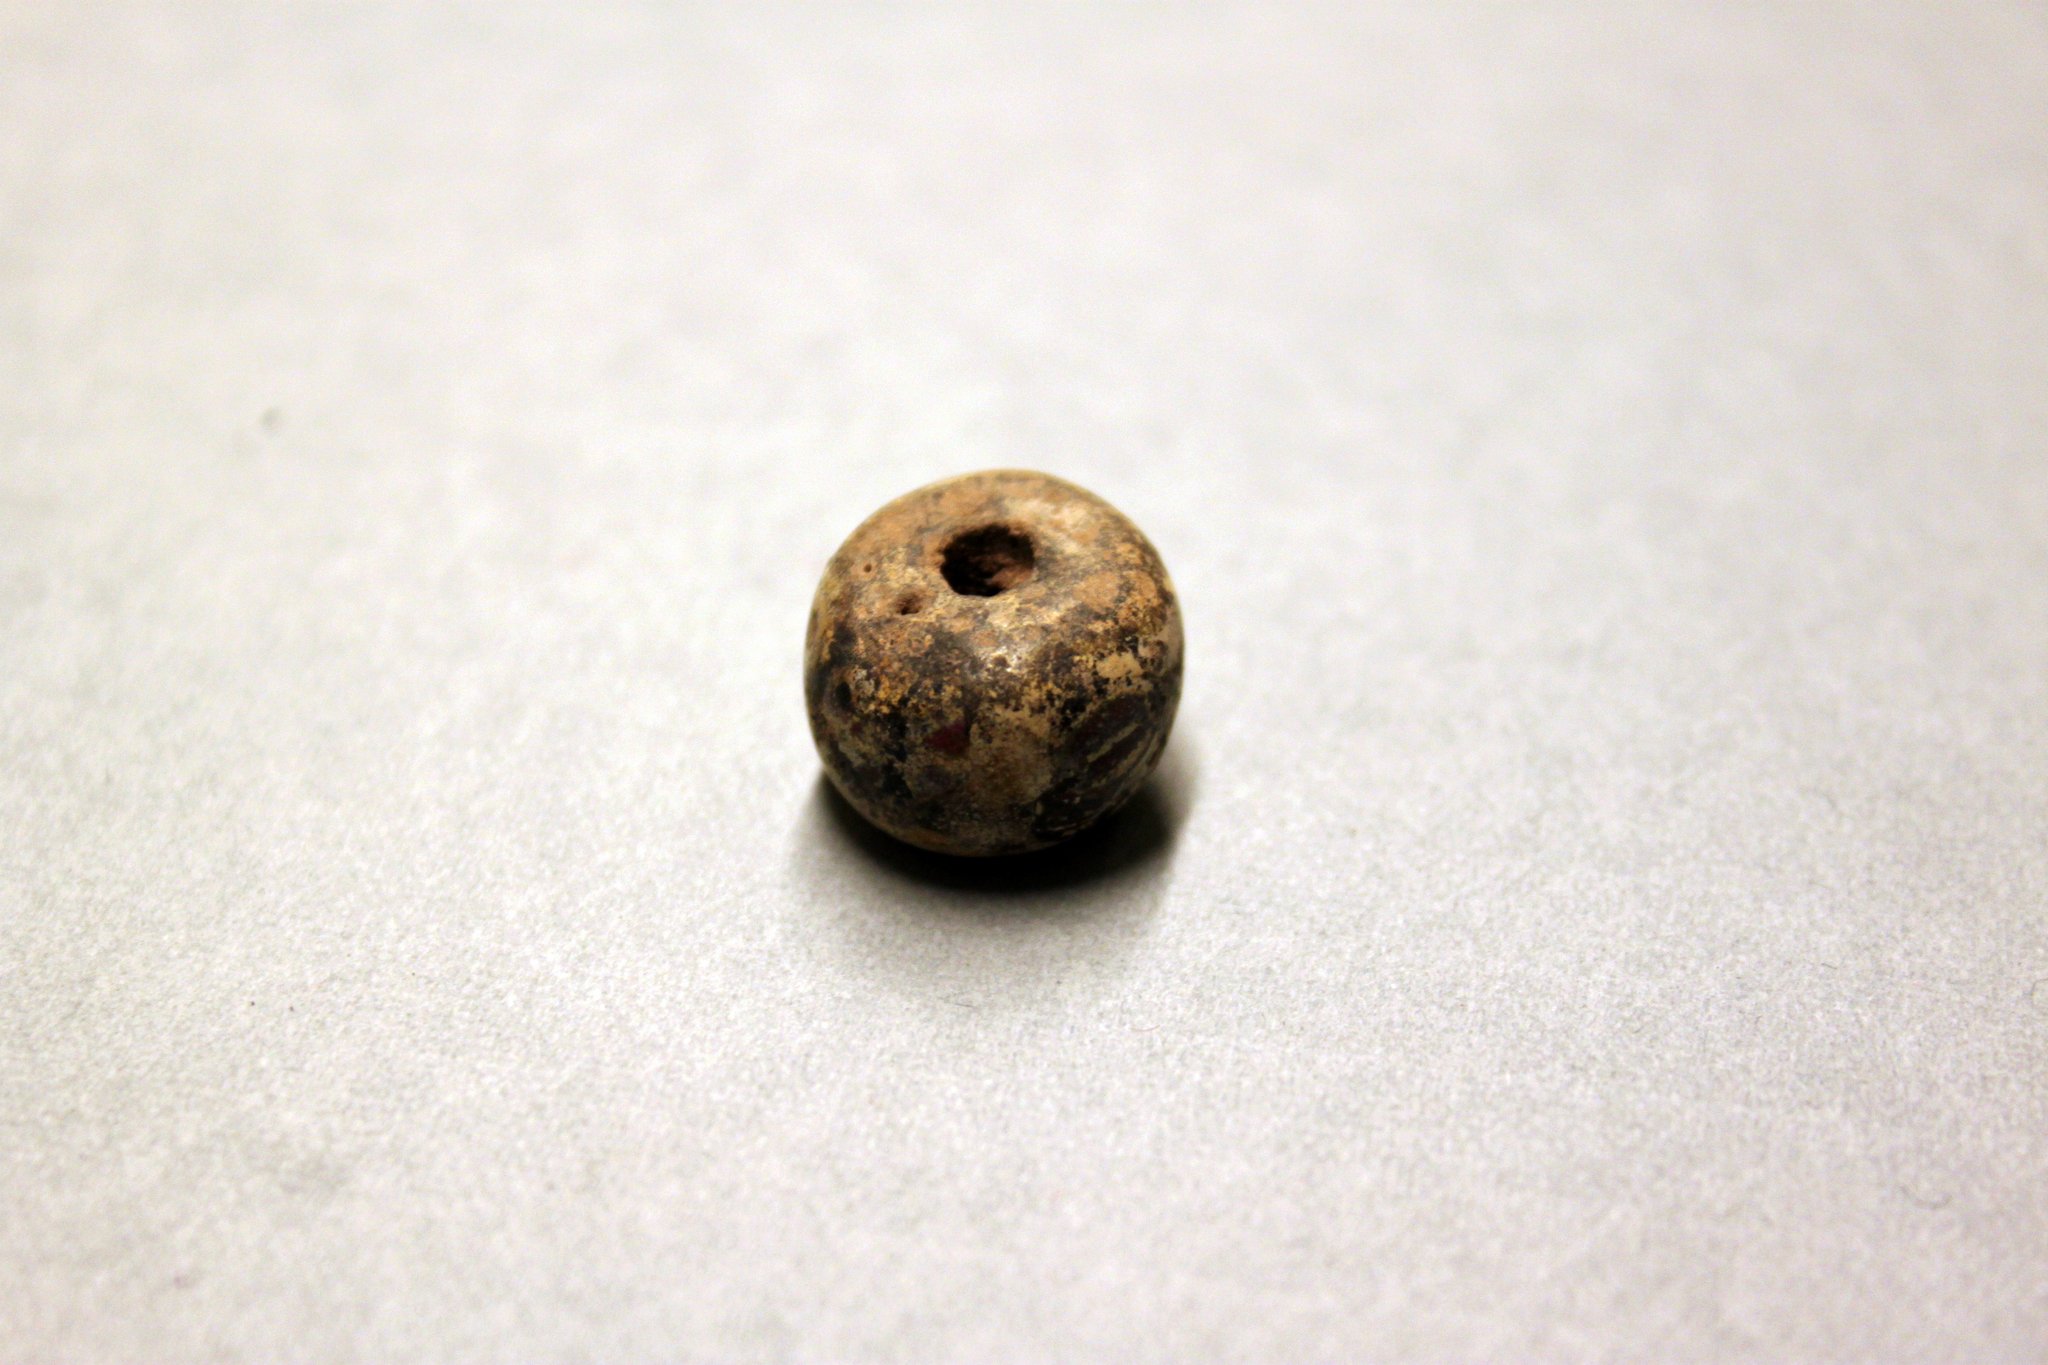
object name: bead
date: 801-1200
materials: glass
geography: iran